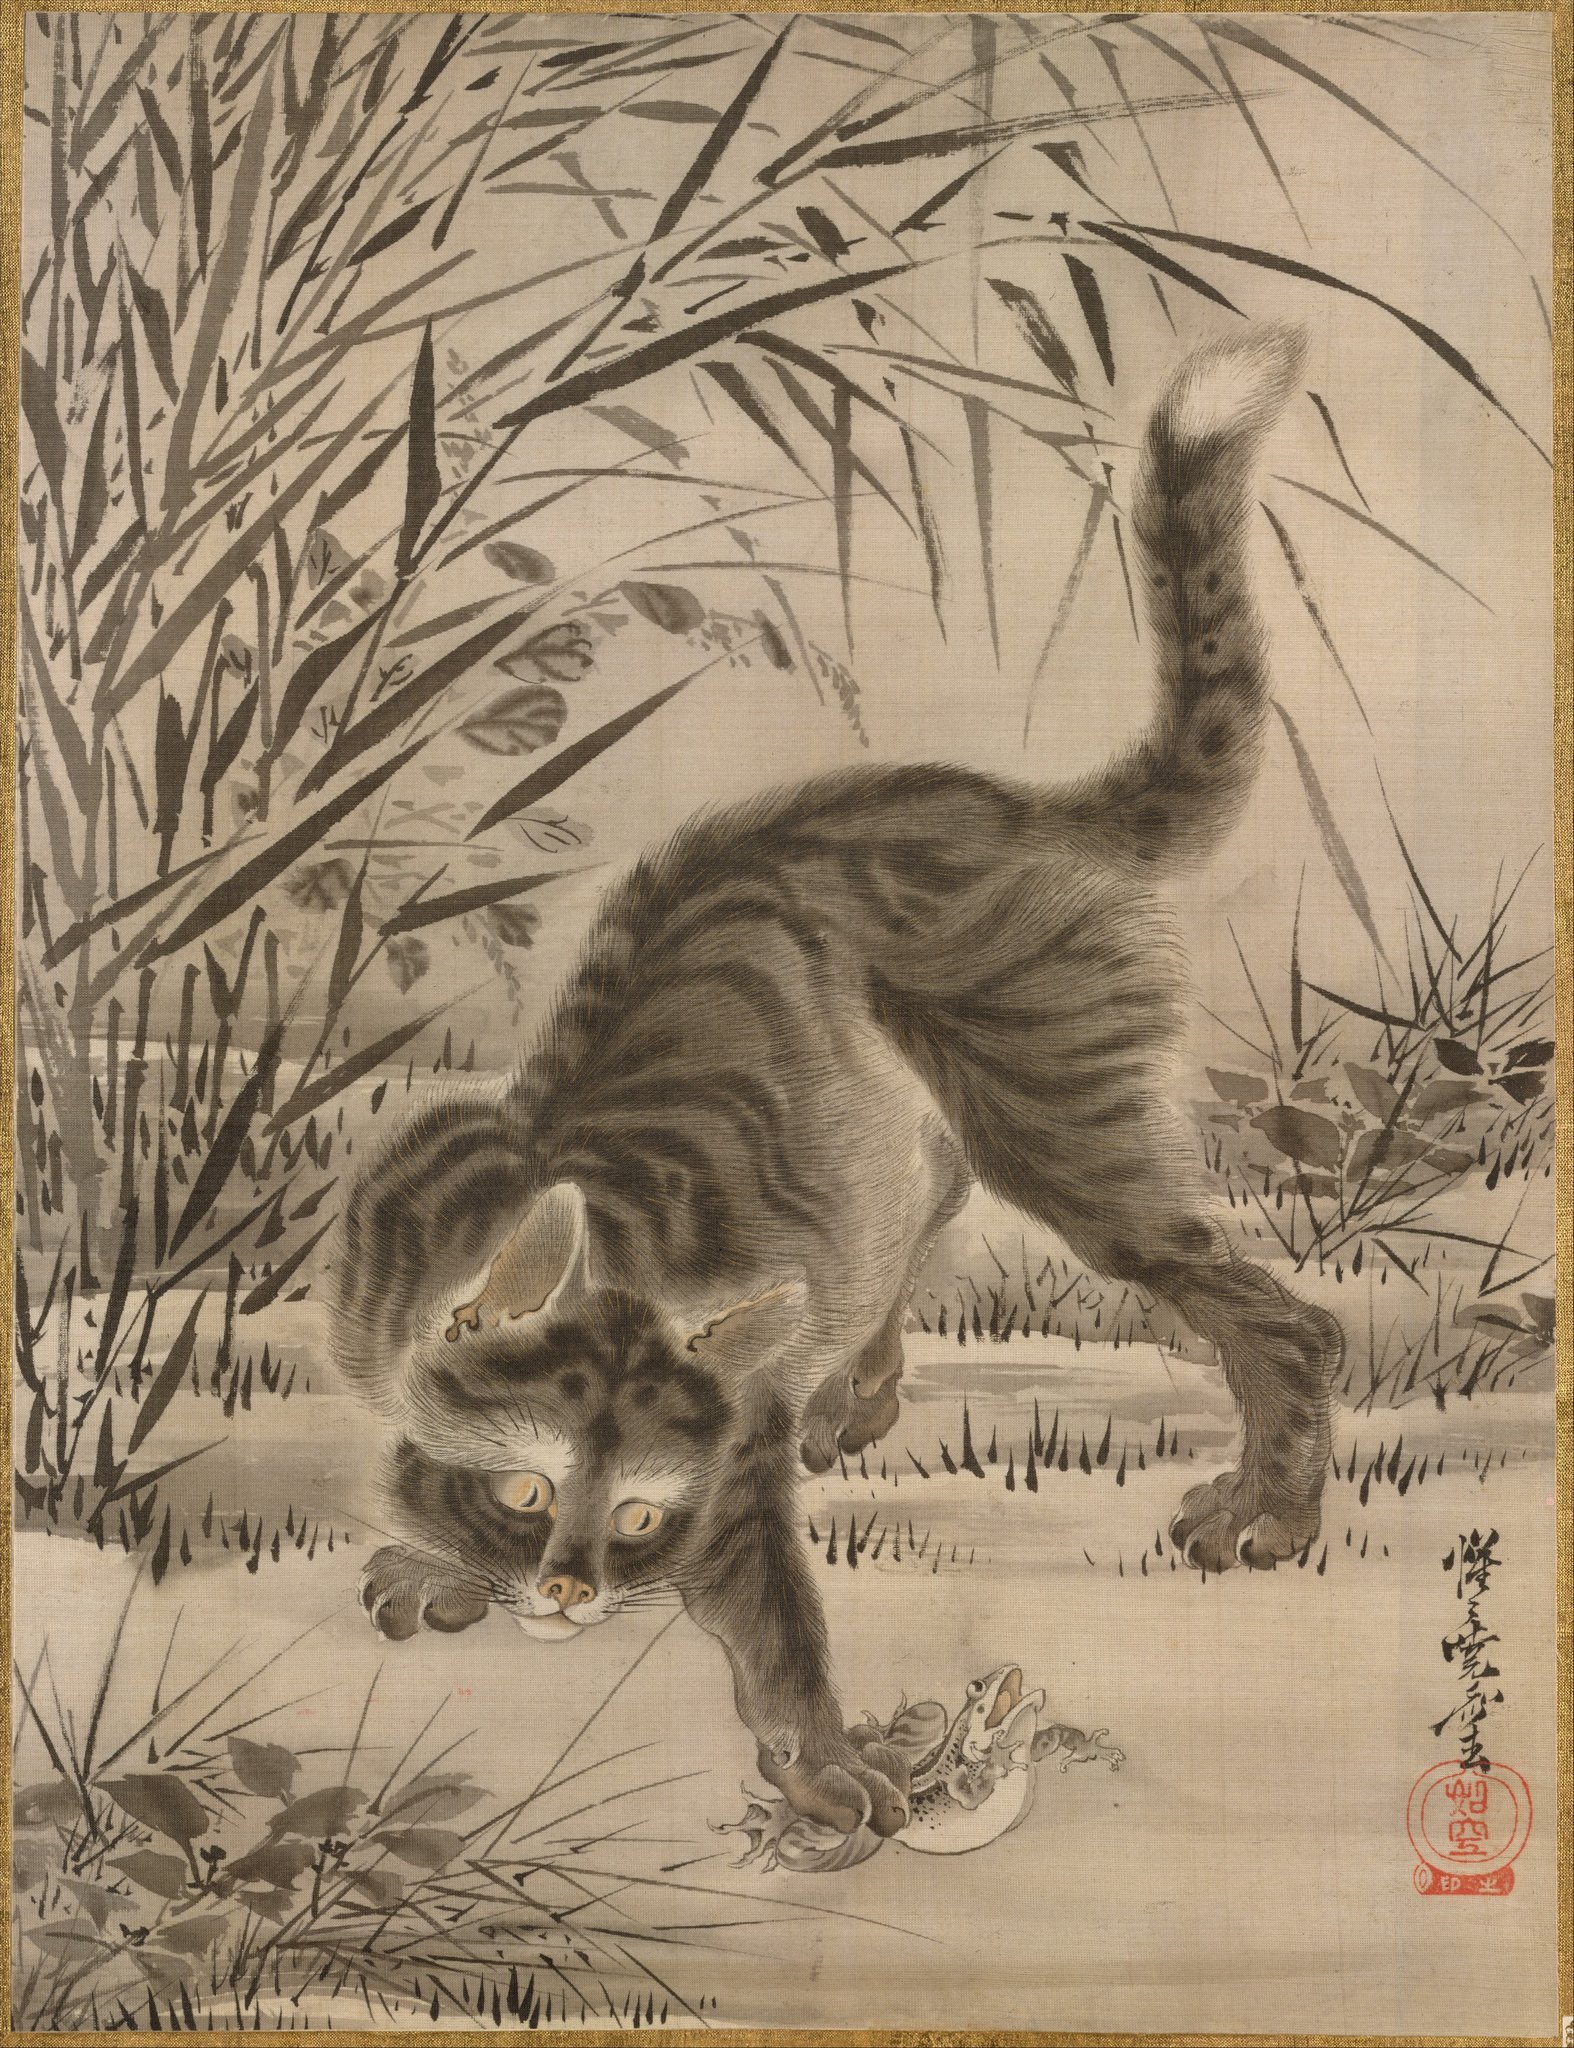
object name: album leaf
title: Cat Catching a Frog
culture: japanese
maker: kawanabe kyōsai 河鍋暁斎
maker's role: artist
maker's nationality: japanese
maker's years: 1831-1889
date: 1887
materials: ink, silk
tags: cats,frogs